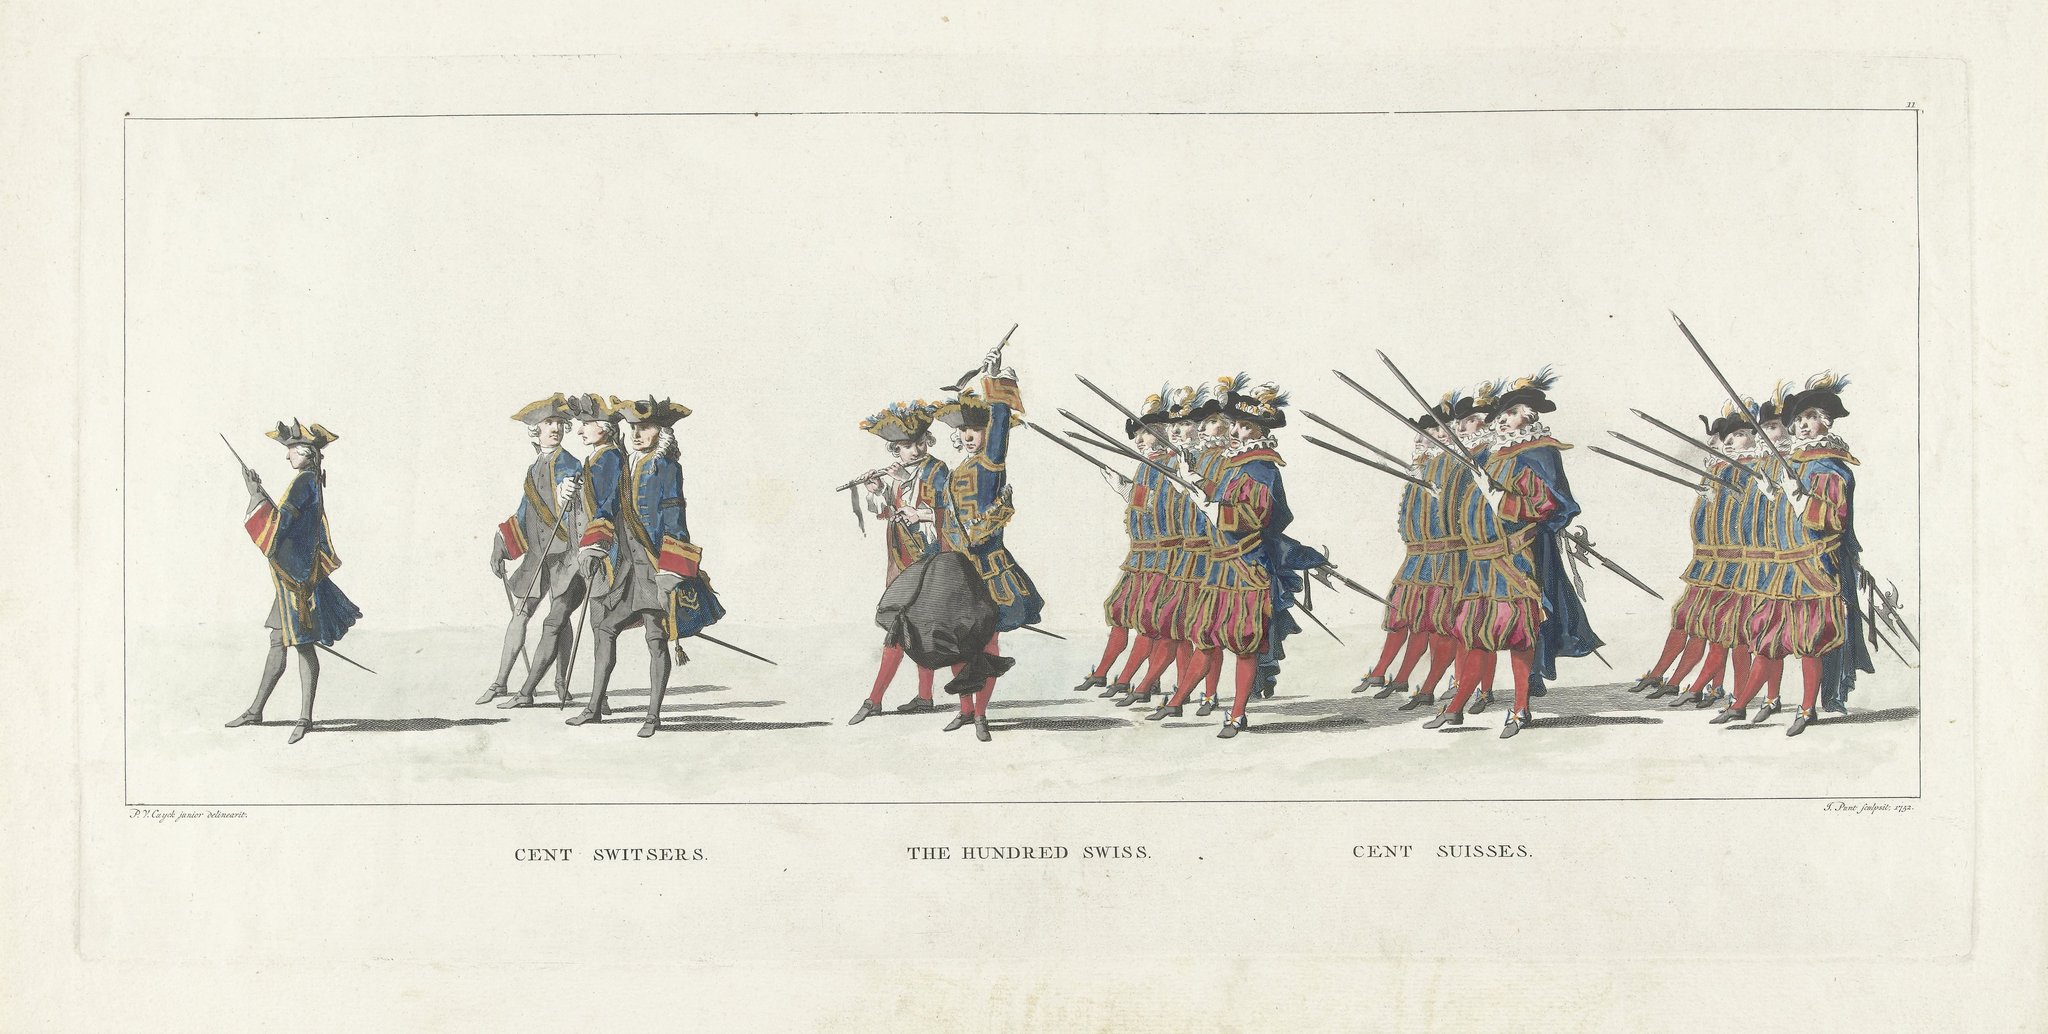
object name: print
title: Cent Switsers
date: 1752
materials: paper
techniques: engraving, etching, hand coloring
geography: northern netherlands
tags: the hague, willem iv (prins van oranje-nassau), military parade, pageant (+ infantry), cortege, funeral procession, delft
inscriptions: collector's mark: Lugt 2228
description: De Cent-Suisses. In de marge het onderschrift in Nederlands, Frans en Engels. Onderdeel van een serie van 41 platen van de begrafenisstoet van stadhouder Willem IV te Delft op 4 februari 1752. Genummerd rechtsboven: 11.